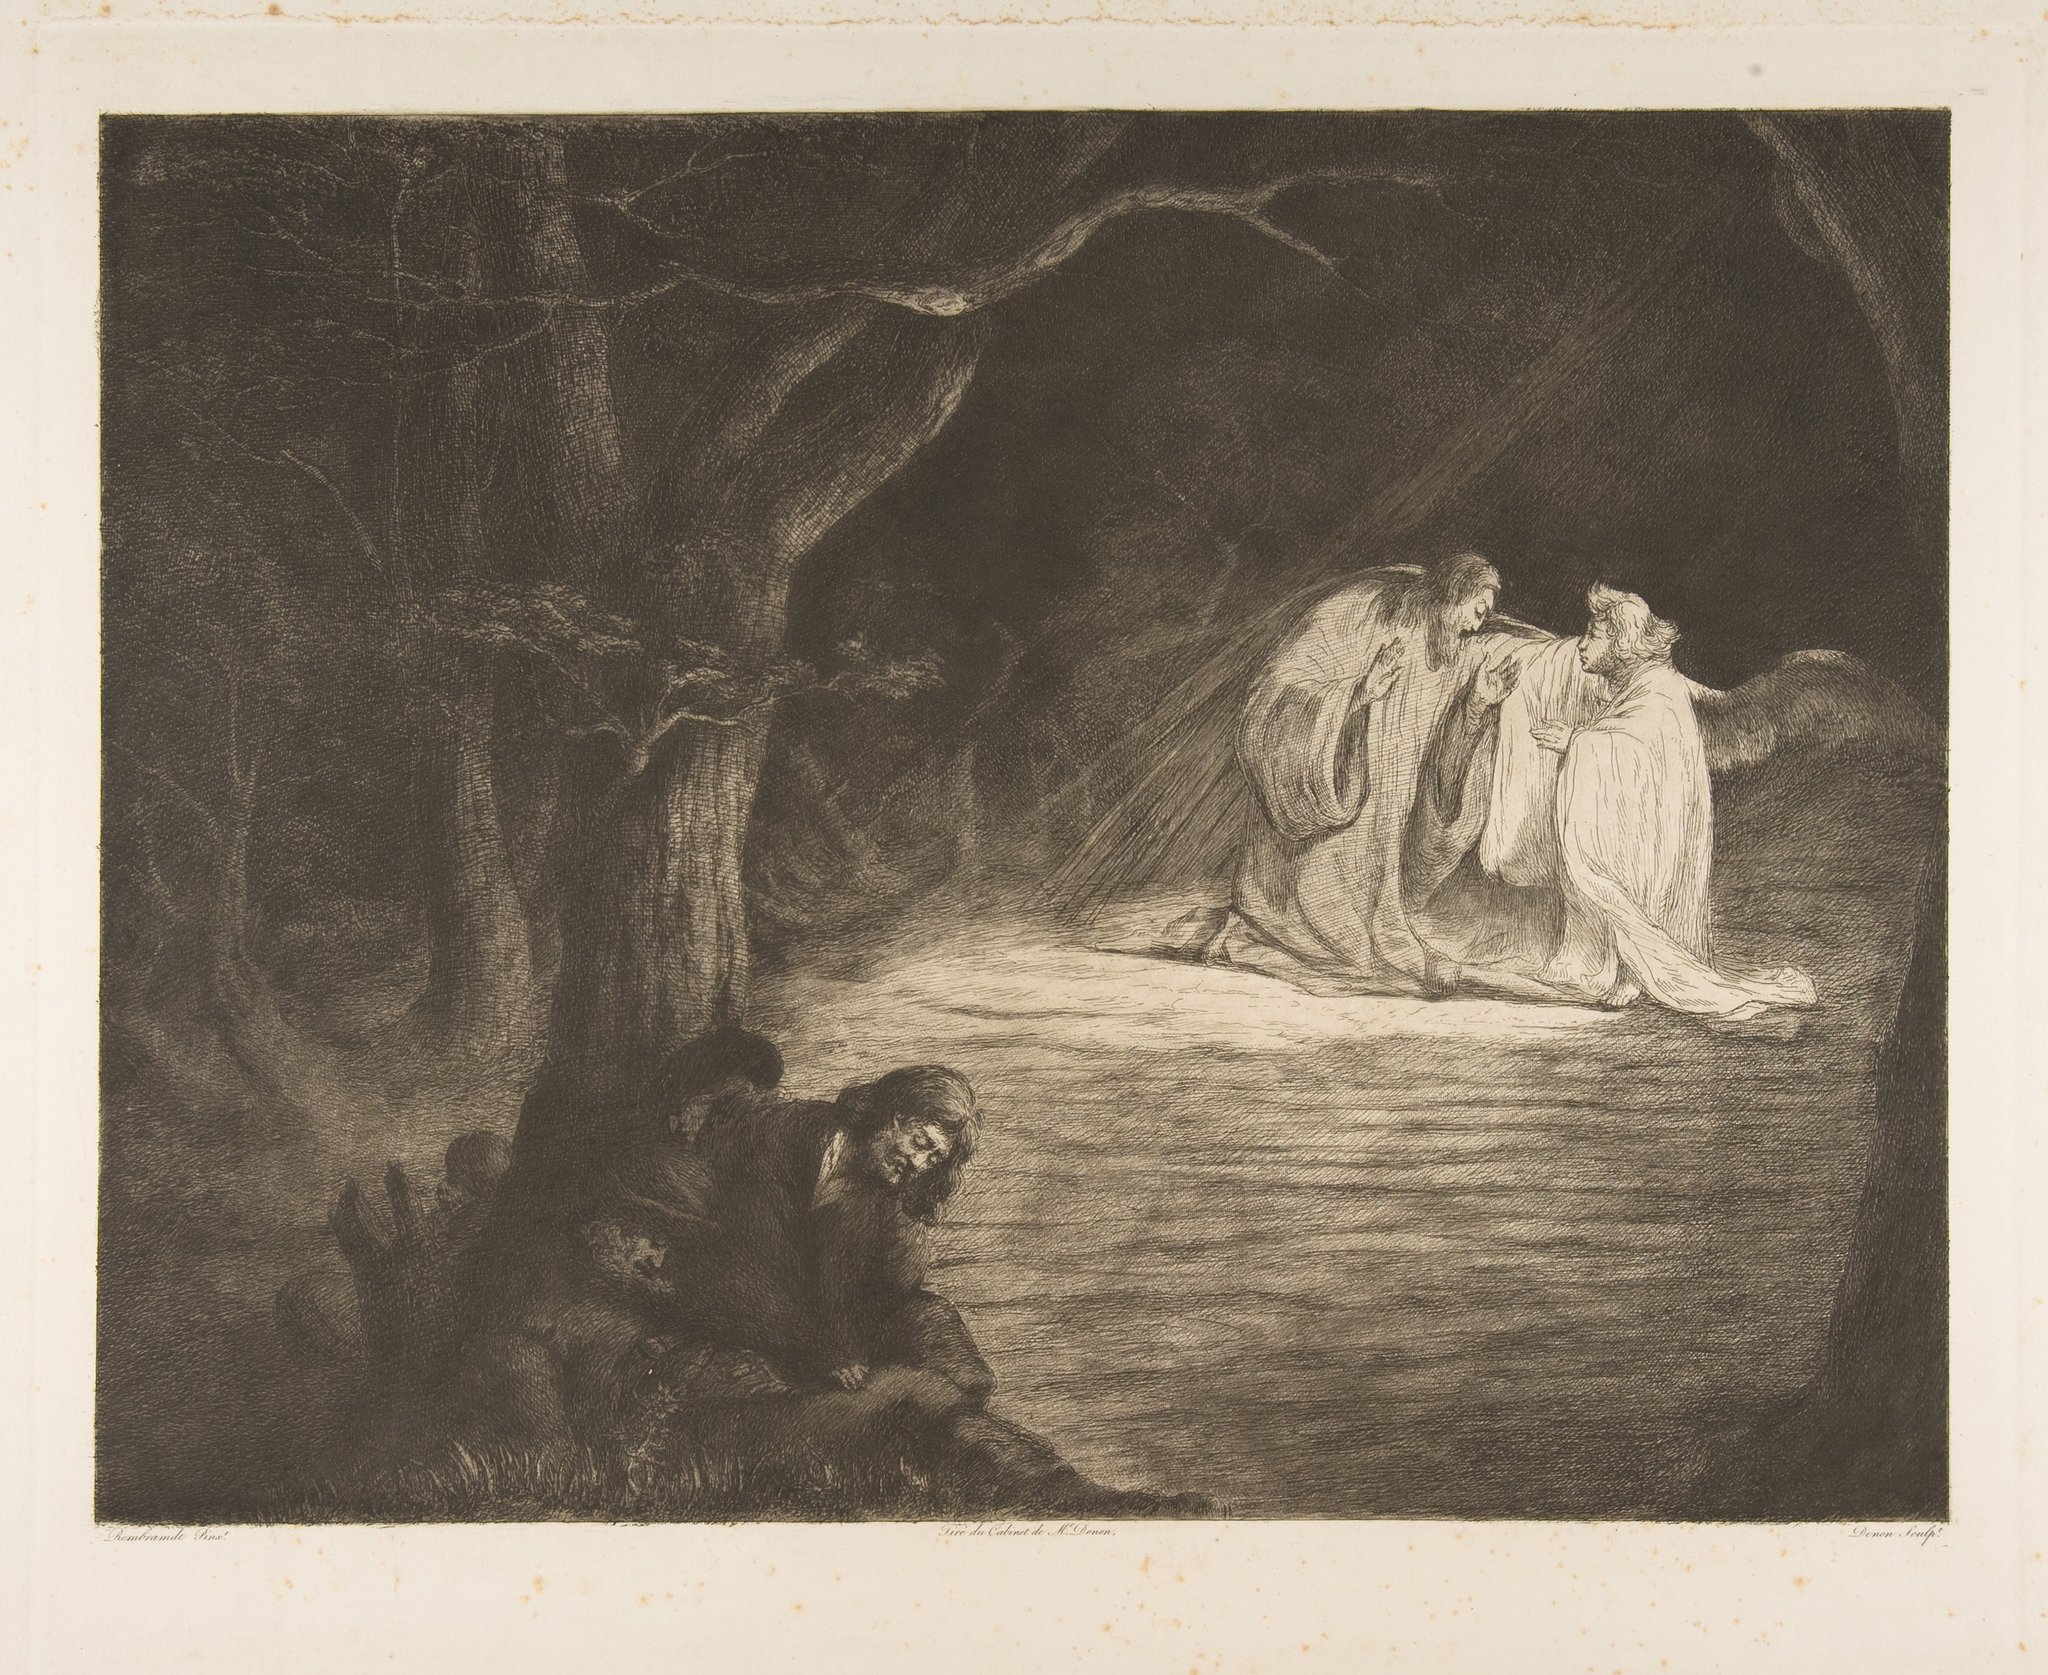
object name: print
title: Christ on the Mount of Olives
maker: baron dominique vivant denon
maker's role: artist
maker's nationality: french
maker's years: 1747-1825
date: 1767-1833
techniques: etching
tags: men,trees,angels,christ